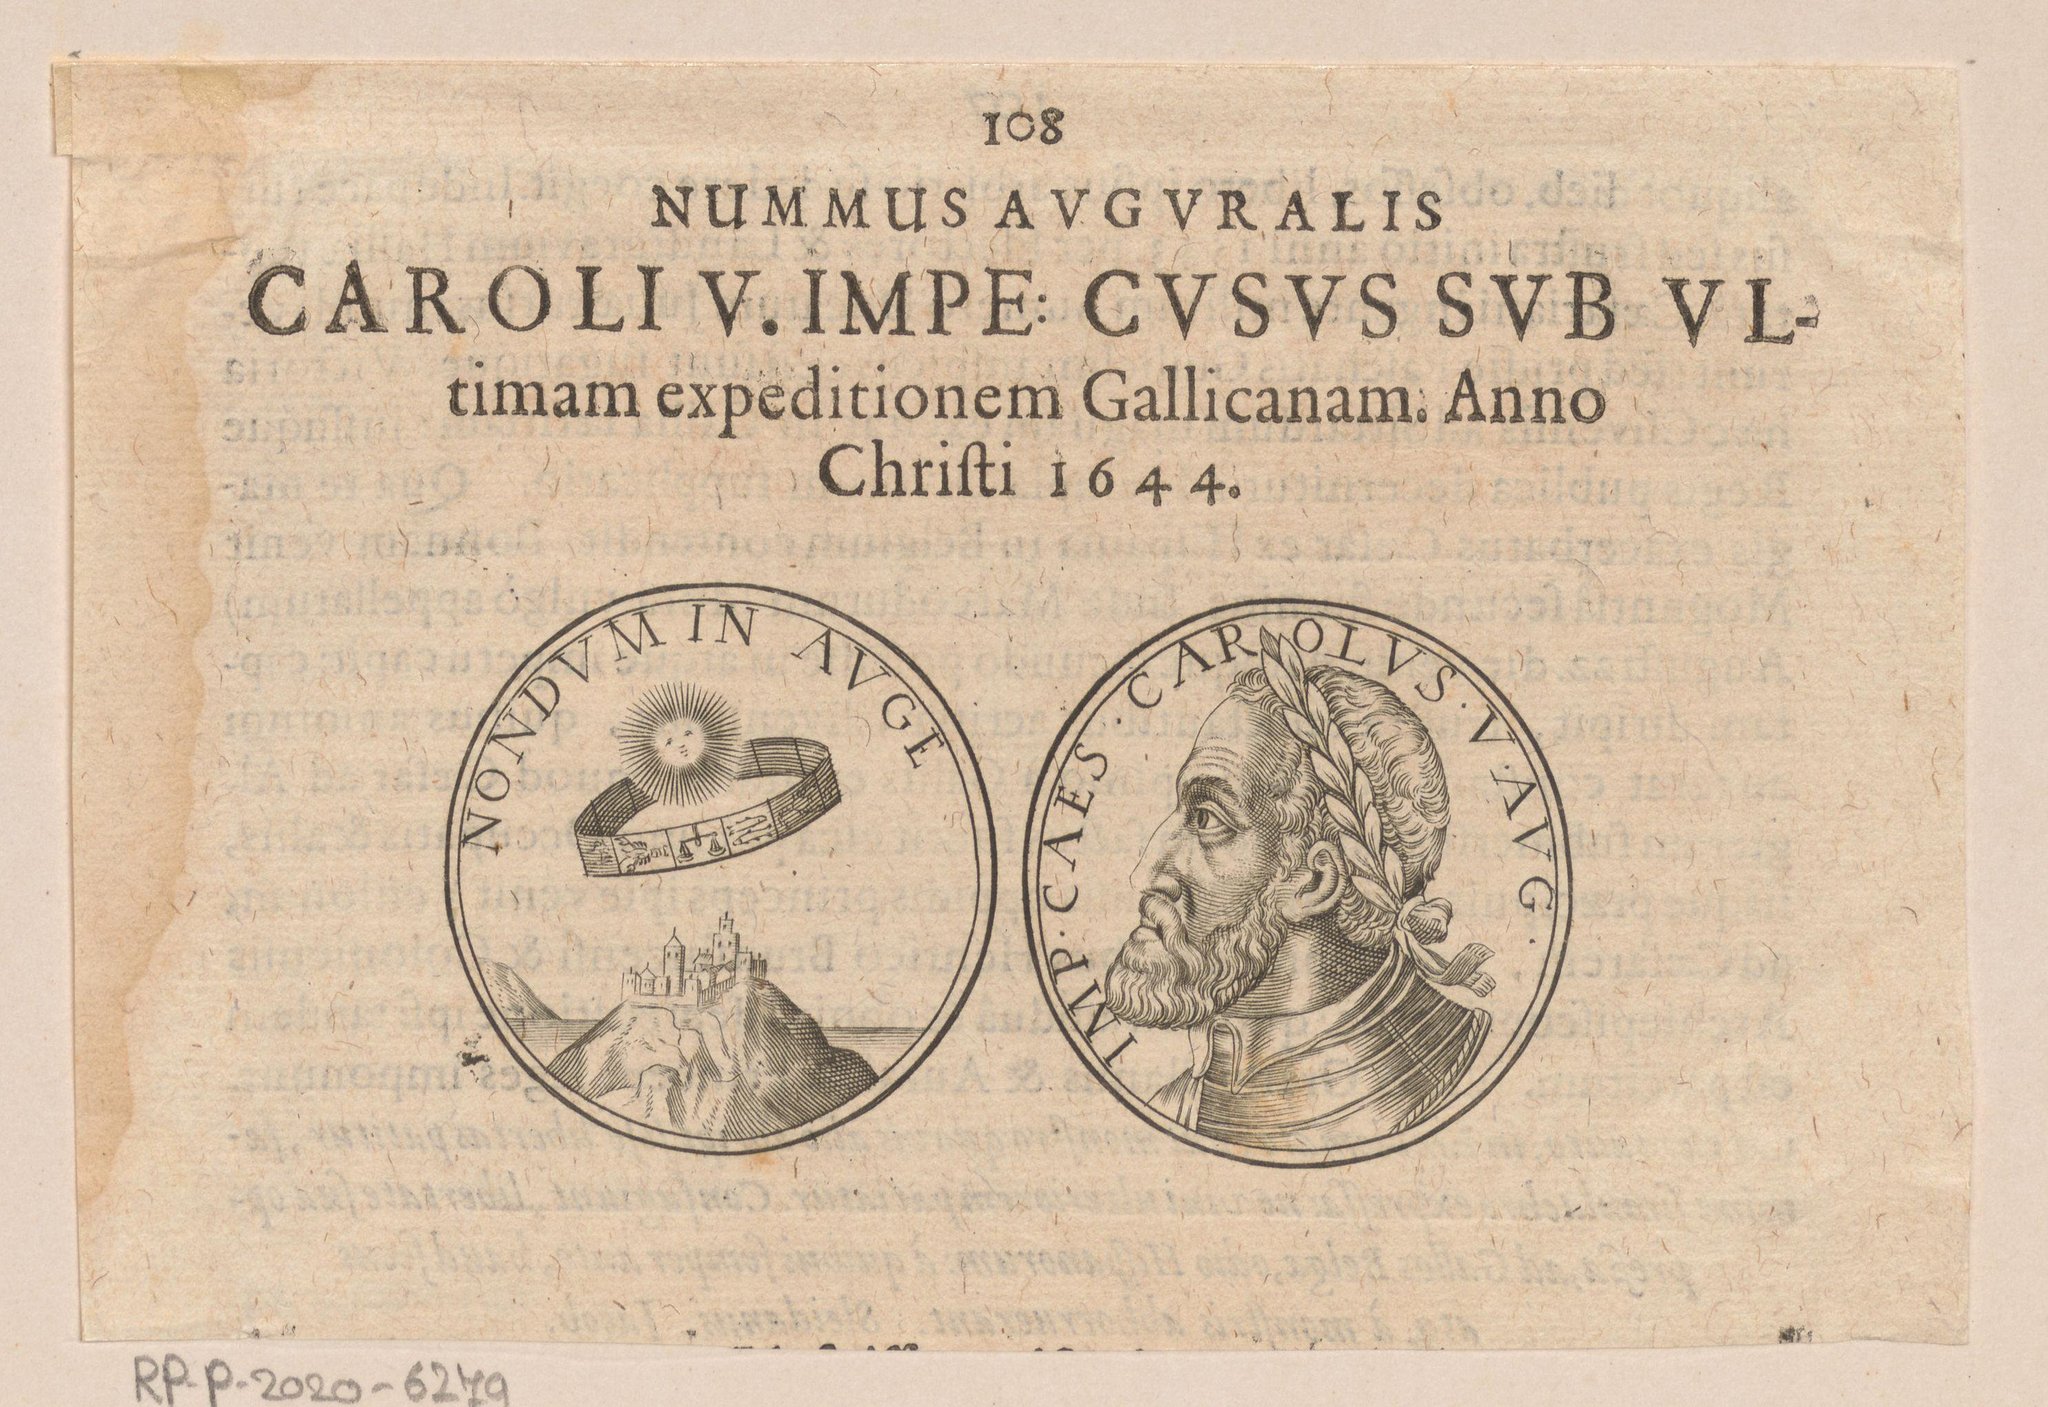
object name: print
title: Medaille met het portret van keizer Karel V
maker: Anonymous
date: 1620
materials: paper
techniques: engraving, letterpress printing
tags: ghent, charles v (holy roman emperor and king of spain), historical persons, knighthood order of the golden fleece, zodiac; the twelve zodiacal signs together, fortified city, king, dog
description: Prent uit: Lucke, Johann Jacob. Sylloge numismatum elegantiorum quae diuersi (...). S.l.s.n.,1620, p. 108.